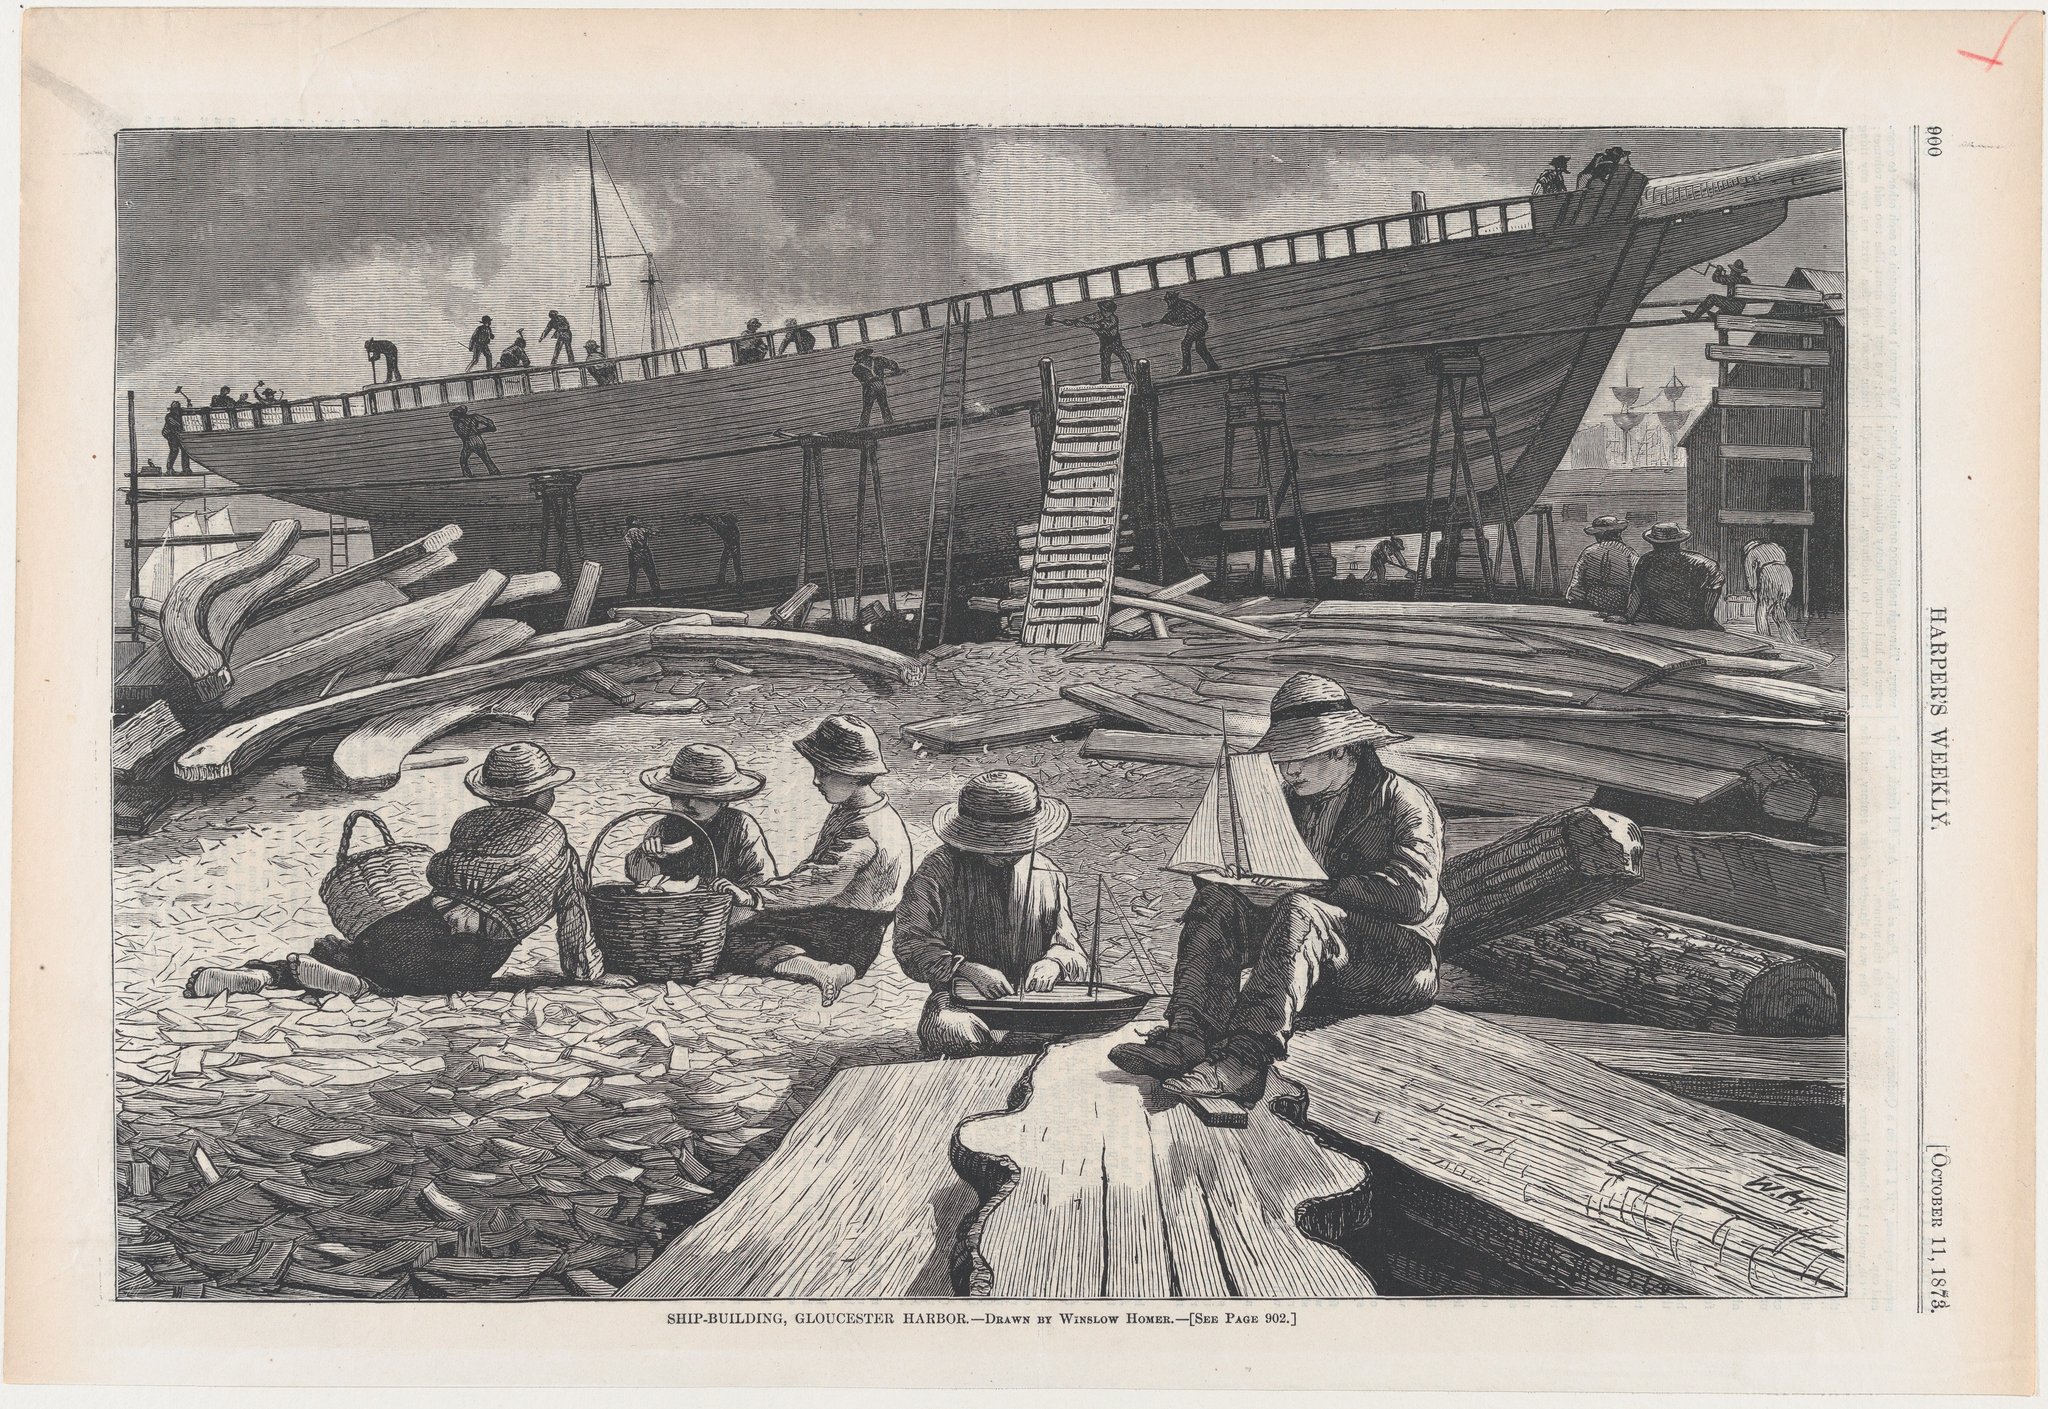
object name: print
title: Ship-Building, Gloucester Harbor (from "Harper's Weekly," Vol. XVII)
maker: winslow homer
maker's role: artist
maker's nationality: american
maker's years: 1836-1910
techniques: engraving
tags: boys,men,working,ships